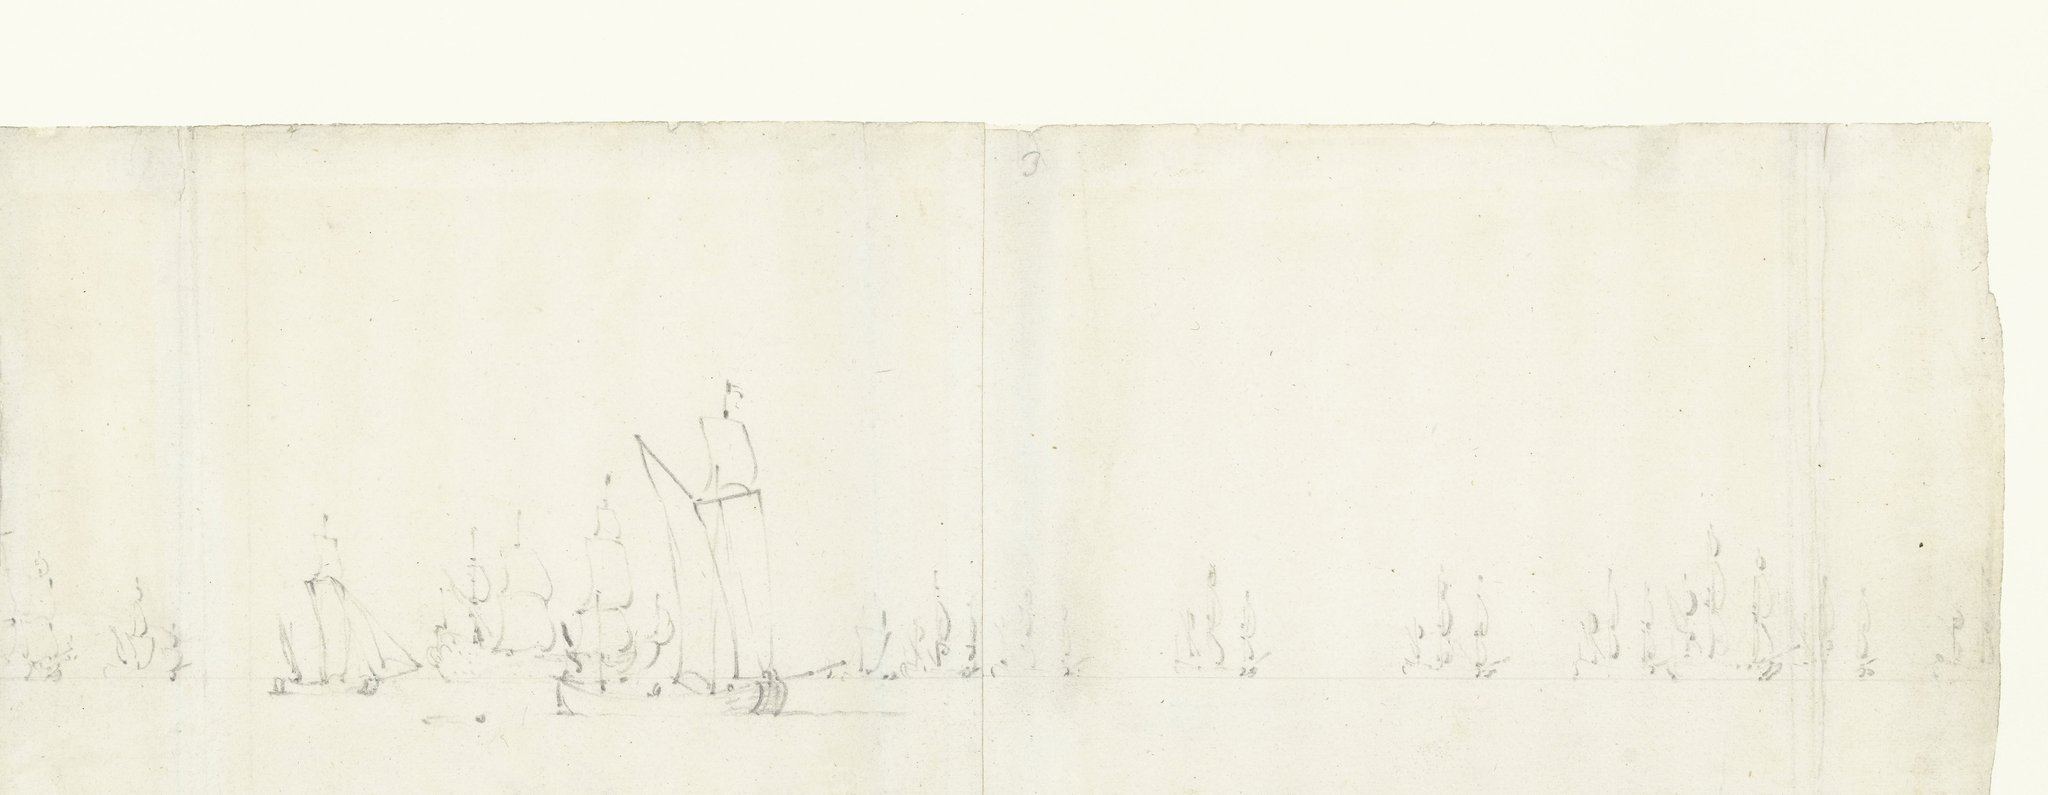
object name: drawing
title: De Vierdaagse Zeeslag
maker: willem van de velde (ii)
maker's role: draughtsman, painter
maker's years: 1633-1707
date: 1666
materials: paper, pencil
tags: sailing-ship, sailing-boat, sea (seascape), battle (+ sailing-ships), navy (+ sailing-ships), historical events and situations